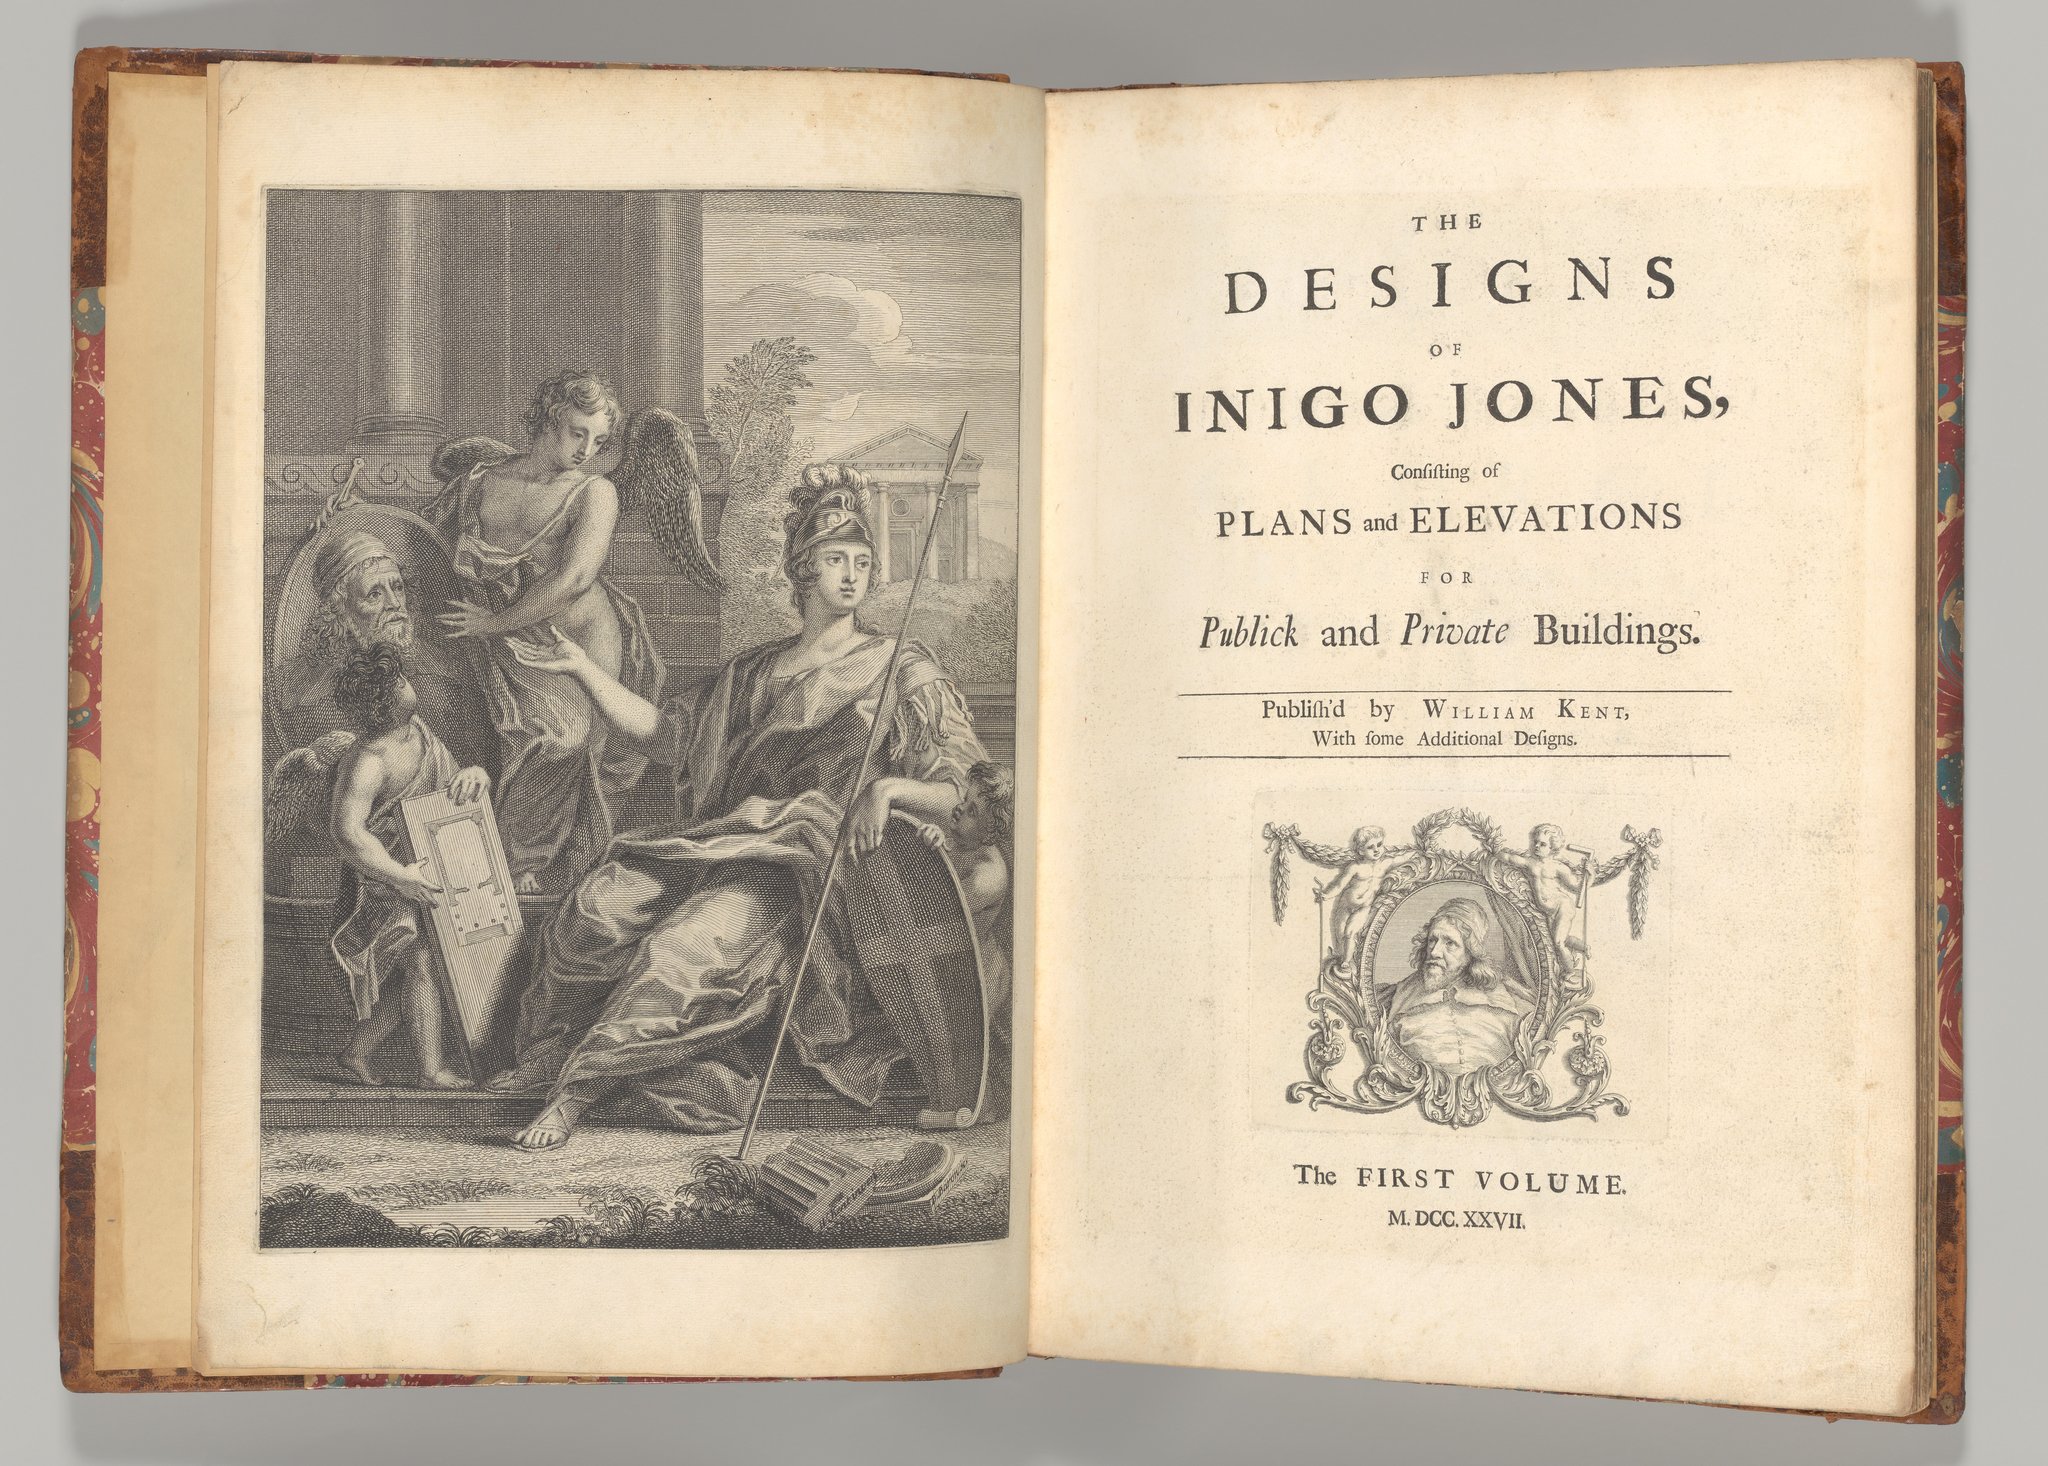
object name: book print ornament architecture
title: The Designs of Inigo Jones, Consisting of Plans and Elevations for Publick and Private Buildings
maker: william kent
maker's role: publisher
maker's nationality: british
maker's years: 1684-1748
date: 1727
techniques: engraving, etching